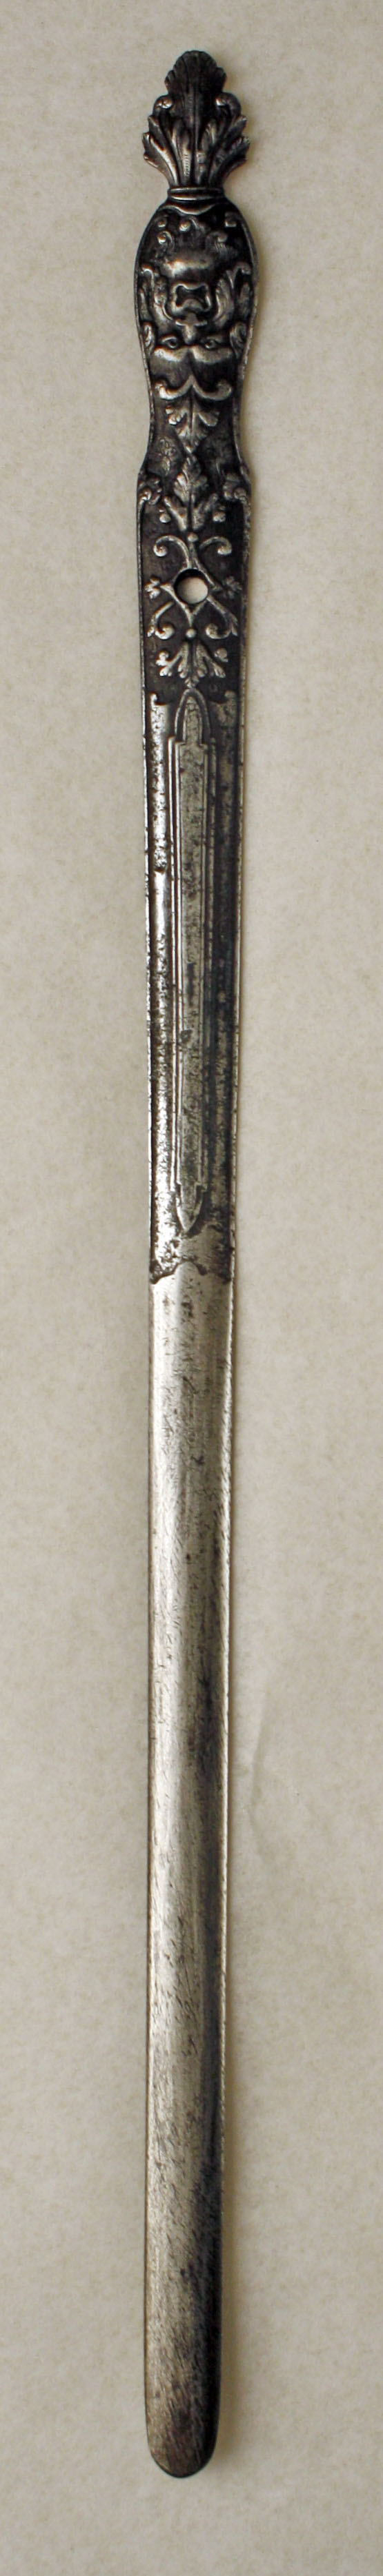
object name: busk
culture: french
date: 1601-1700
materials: metal